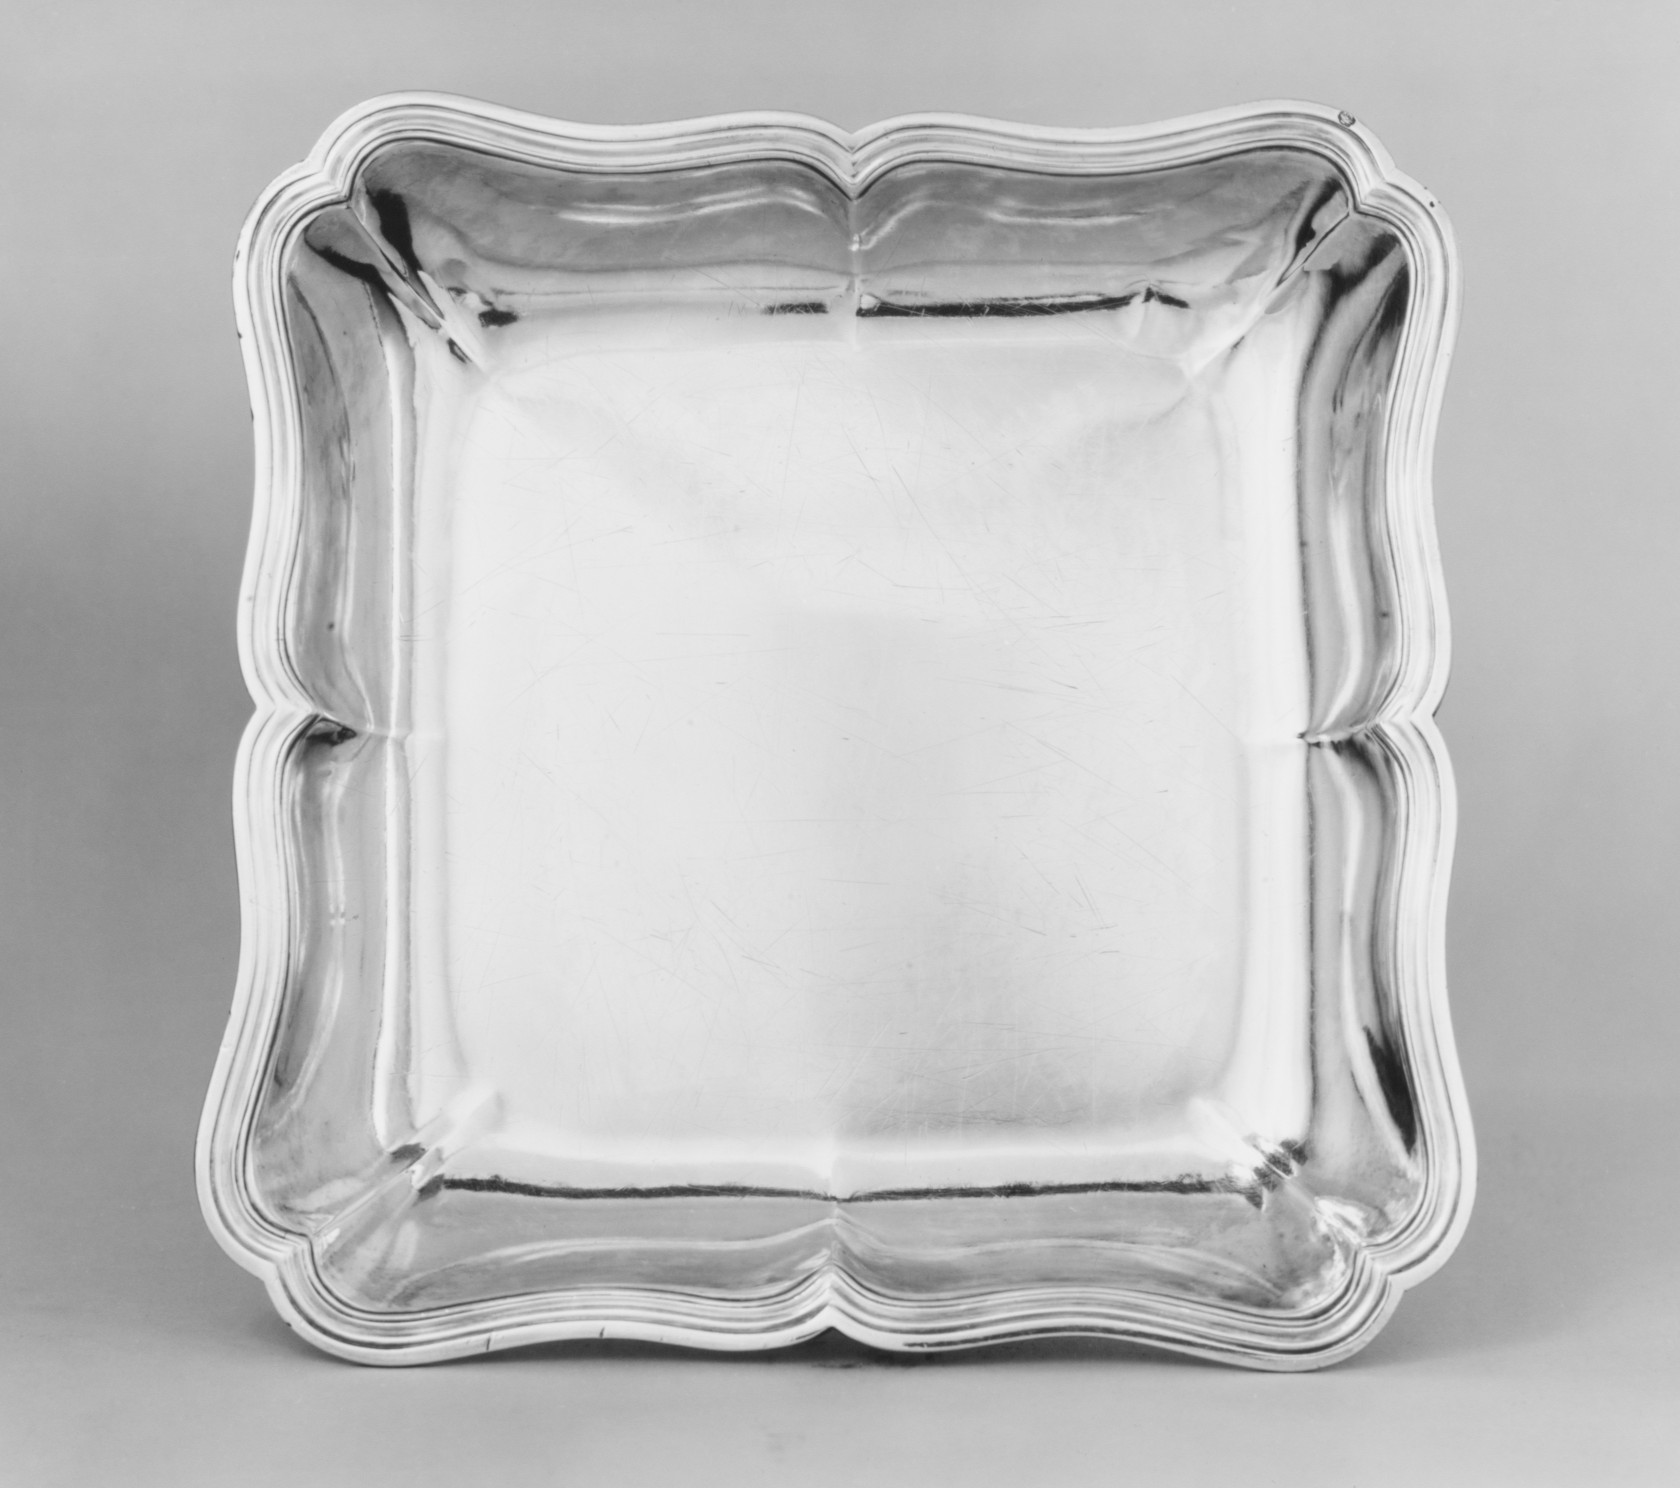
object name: dish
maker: jean antoine bourguet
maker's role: maker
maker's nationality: french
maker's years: 1758-1785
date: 1765-1766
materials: silver